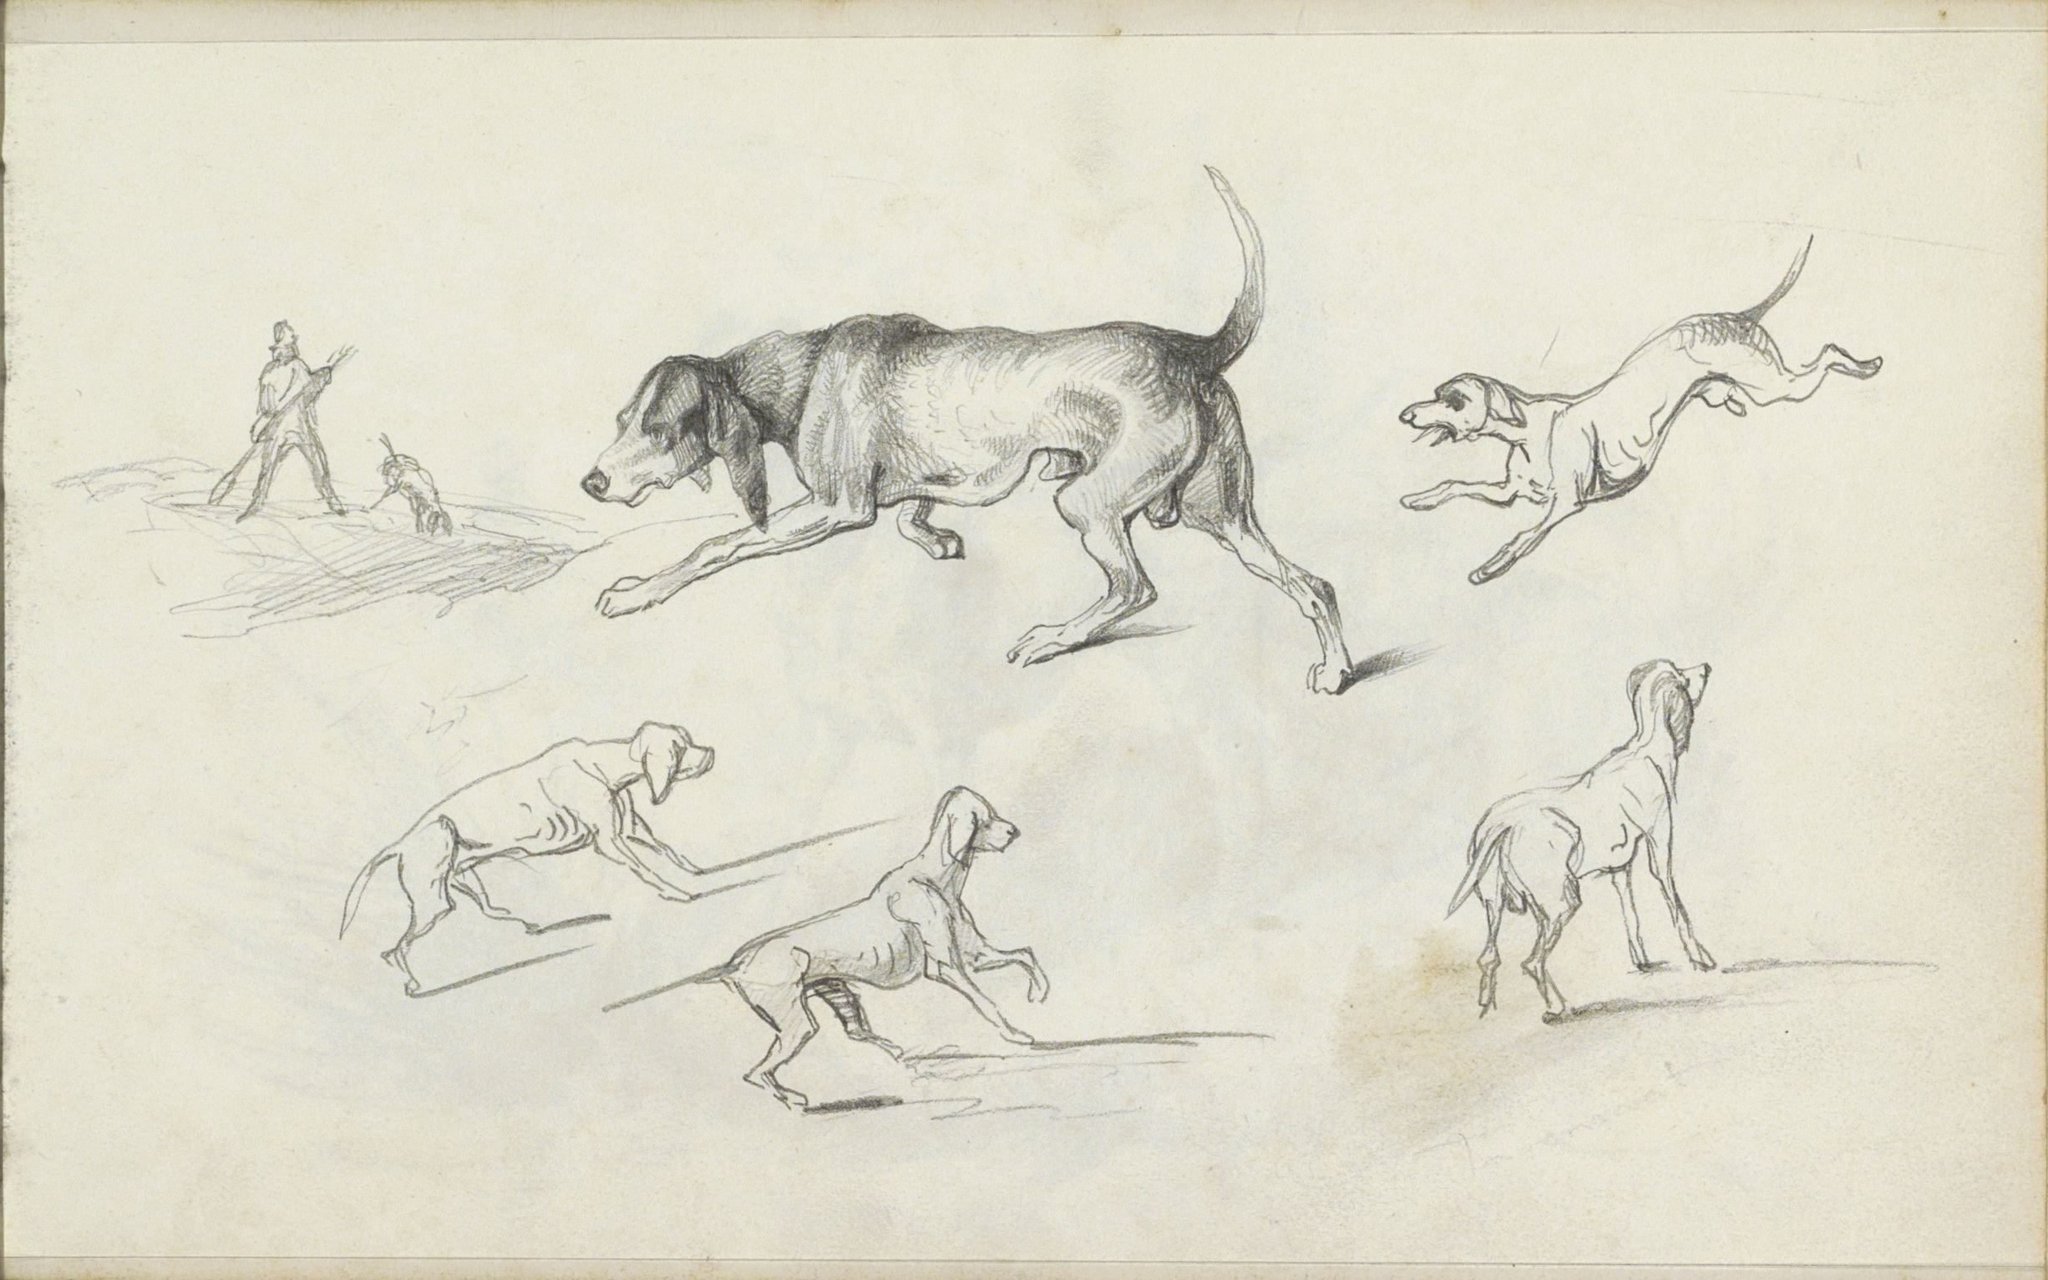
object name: sketchbook leaf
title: Jager en honden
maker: johannes tavenraat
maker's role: draughtsman, painter, print maker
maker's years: 1809-1881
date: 1843-1844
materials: paper, pencil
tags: hunter, firearms, dog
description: Blad 28 recto uit een schetsboek met 38 bladen.